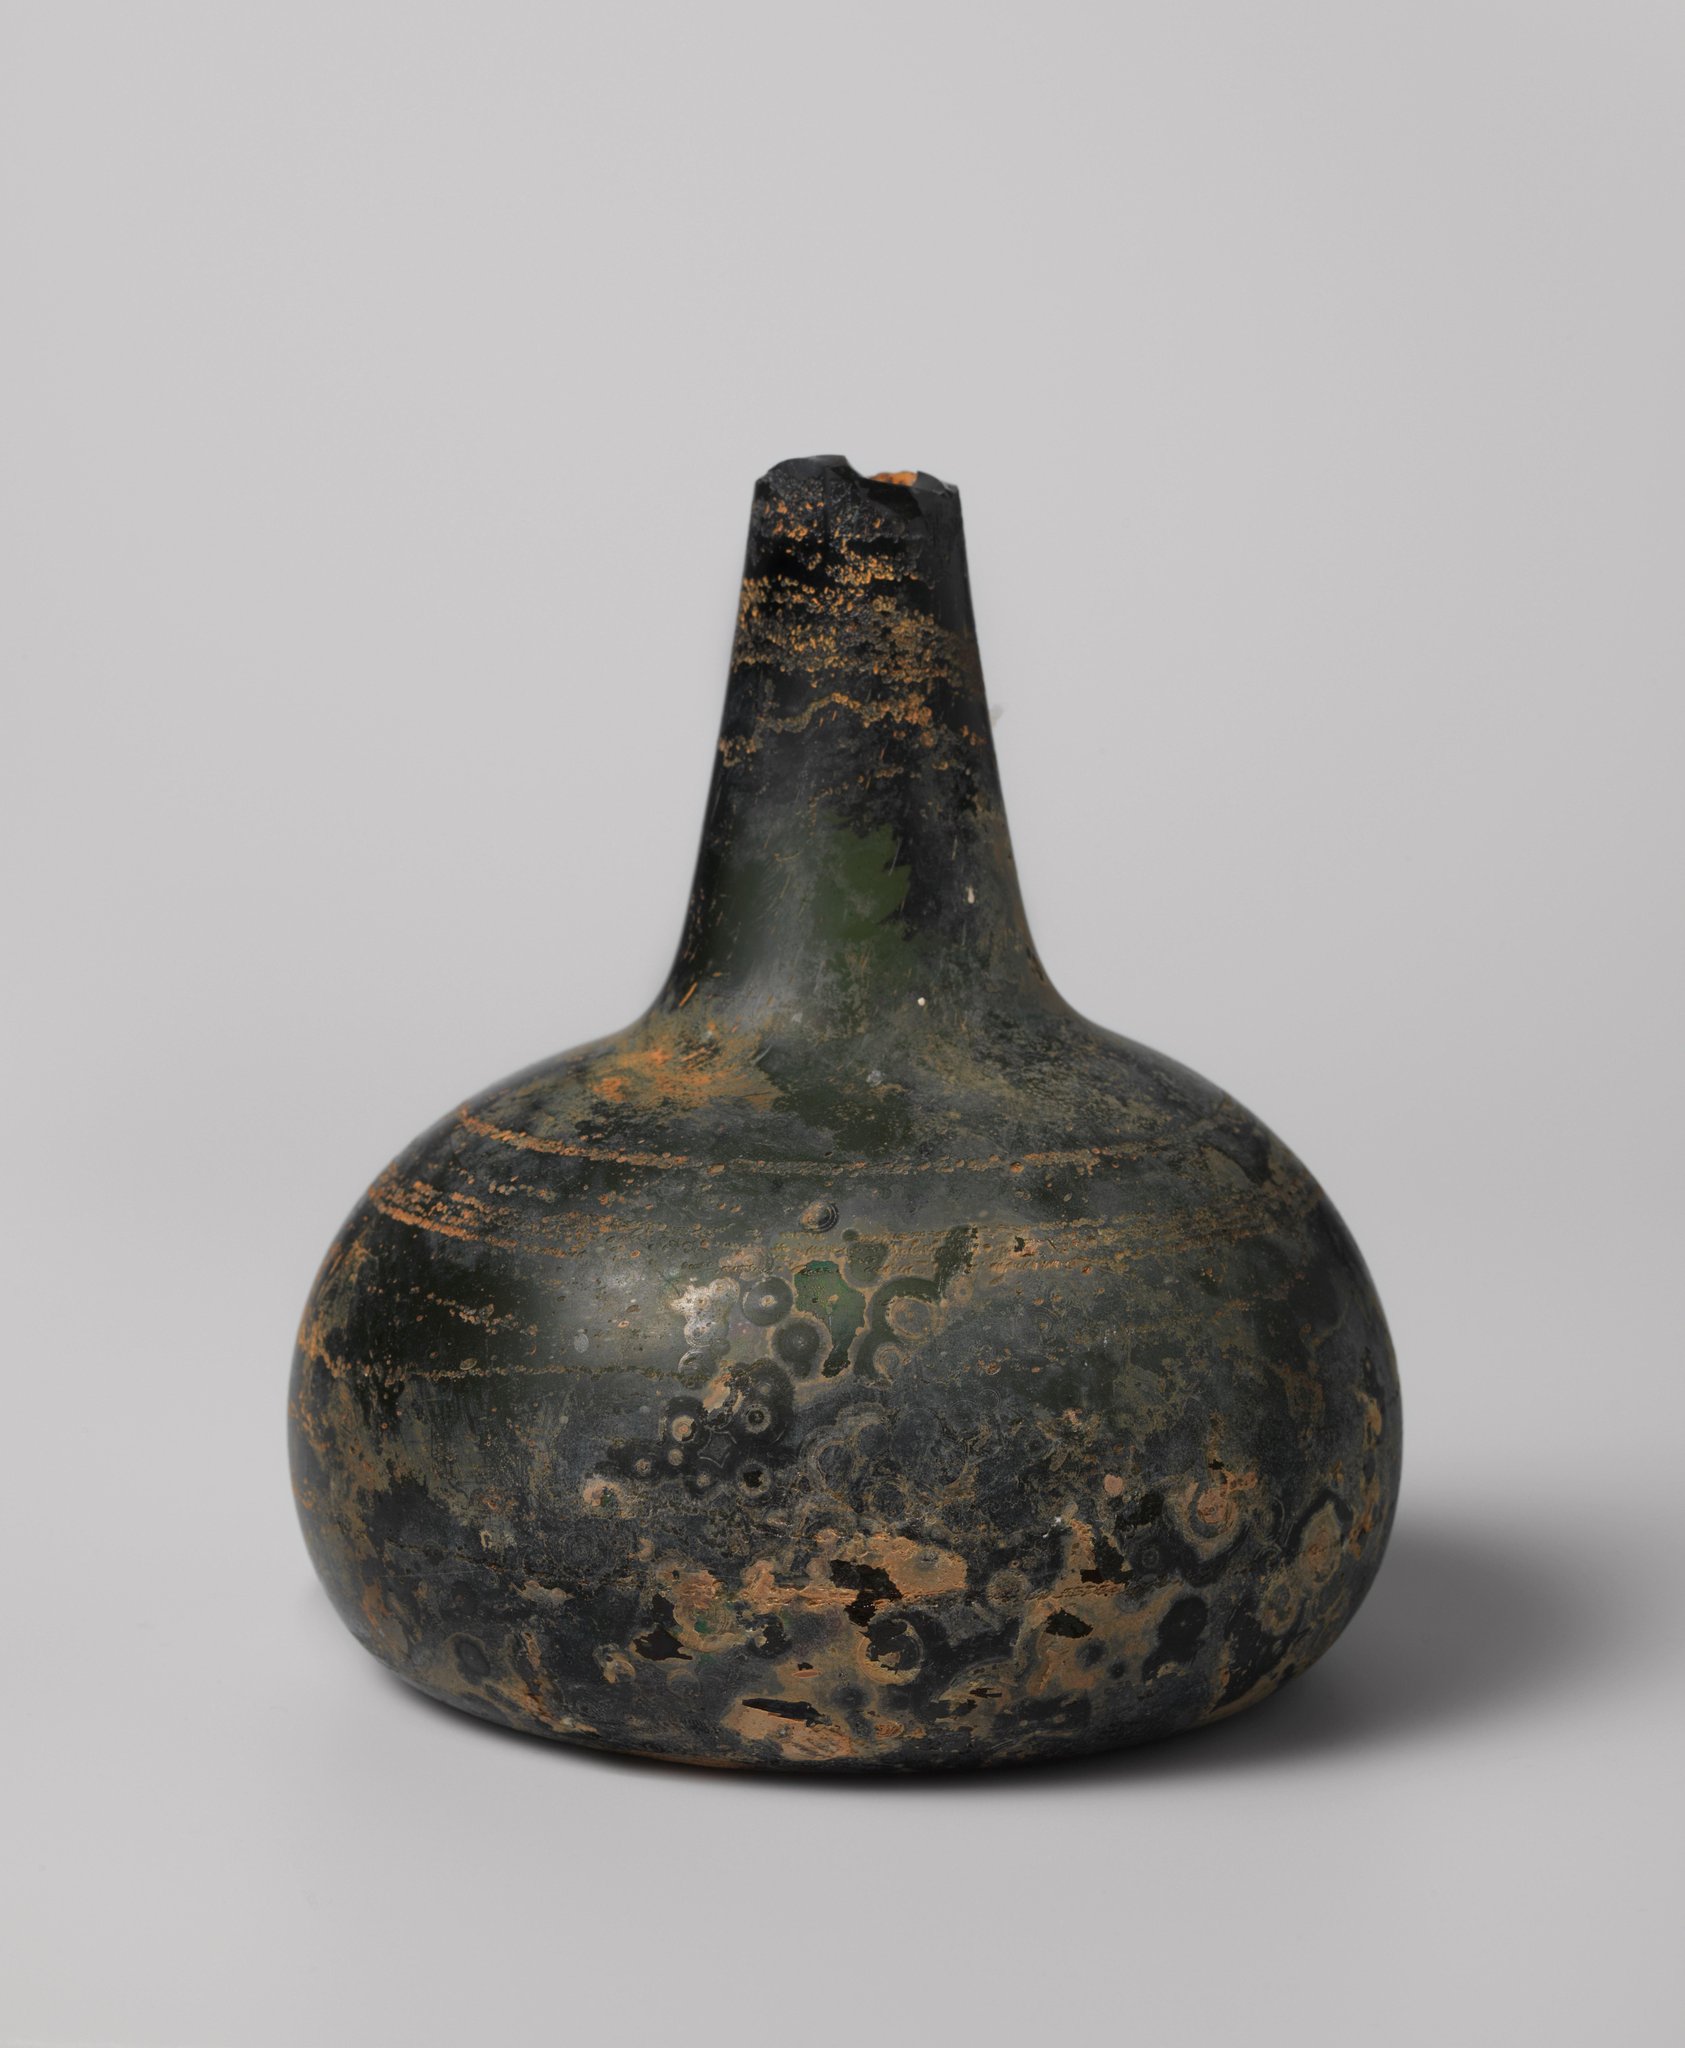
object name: wine bottle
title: Wijnfles uit het wrak van de Oost-Indiëvaarder Hollandia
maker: Anonymous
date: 1700-1743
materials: glass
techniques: green glass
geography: netherlands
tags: verenigde oostindische compagnie, hollandia (schip), annet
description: Wijnfles. De kruk bevindt zich in de fles. Wine bottle, continental production, onion-shaped, mouth missing; (1) (16h, belly 15d, base 10.7d), cs-kick-up.